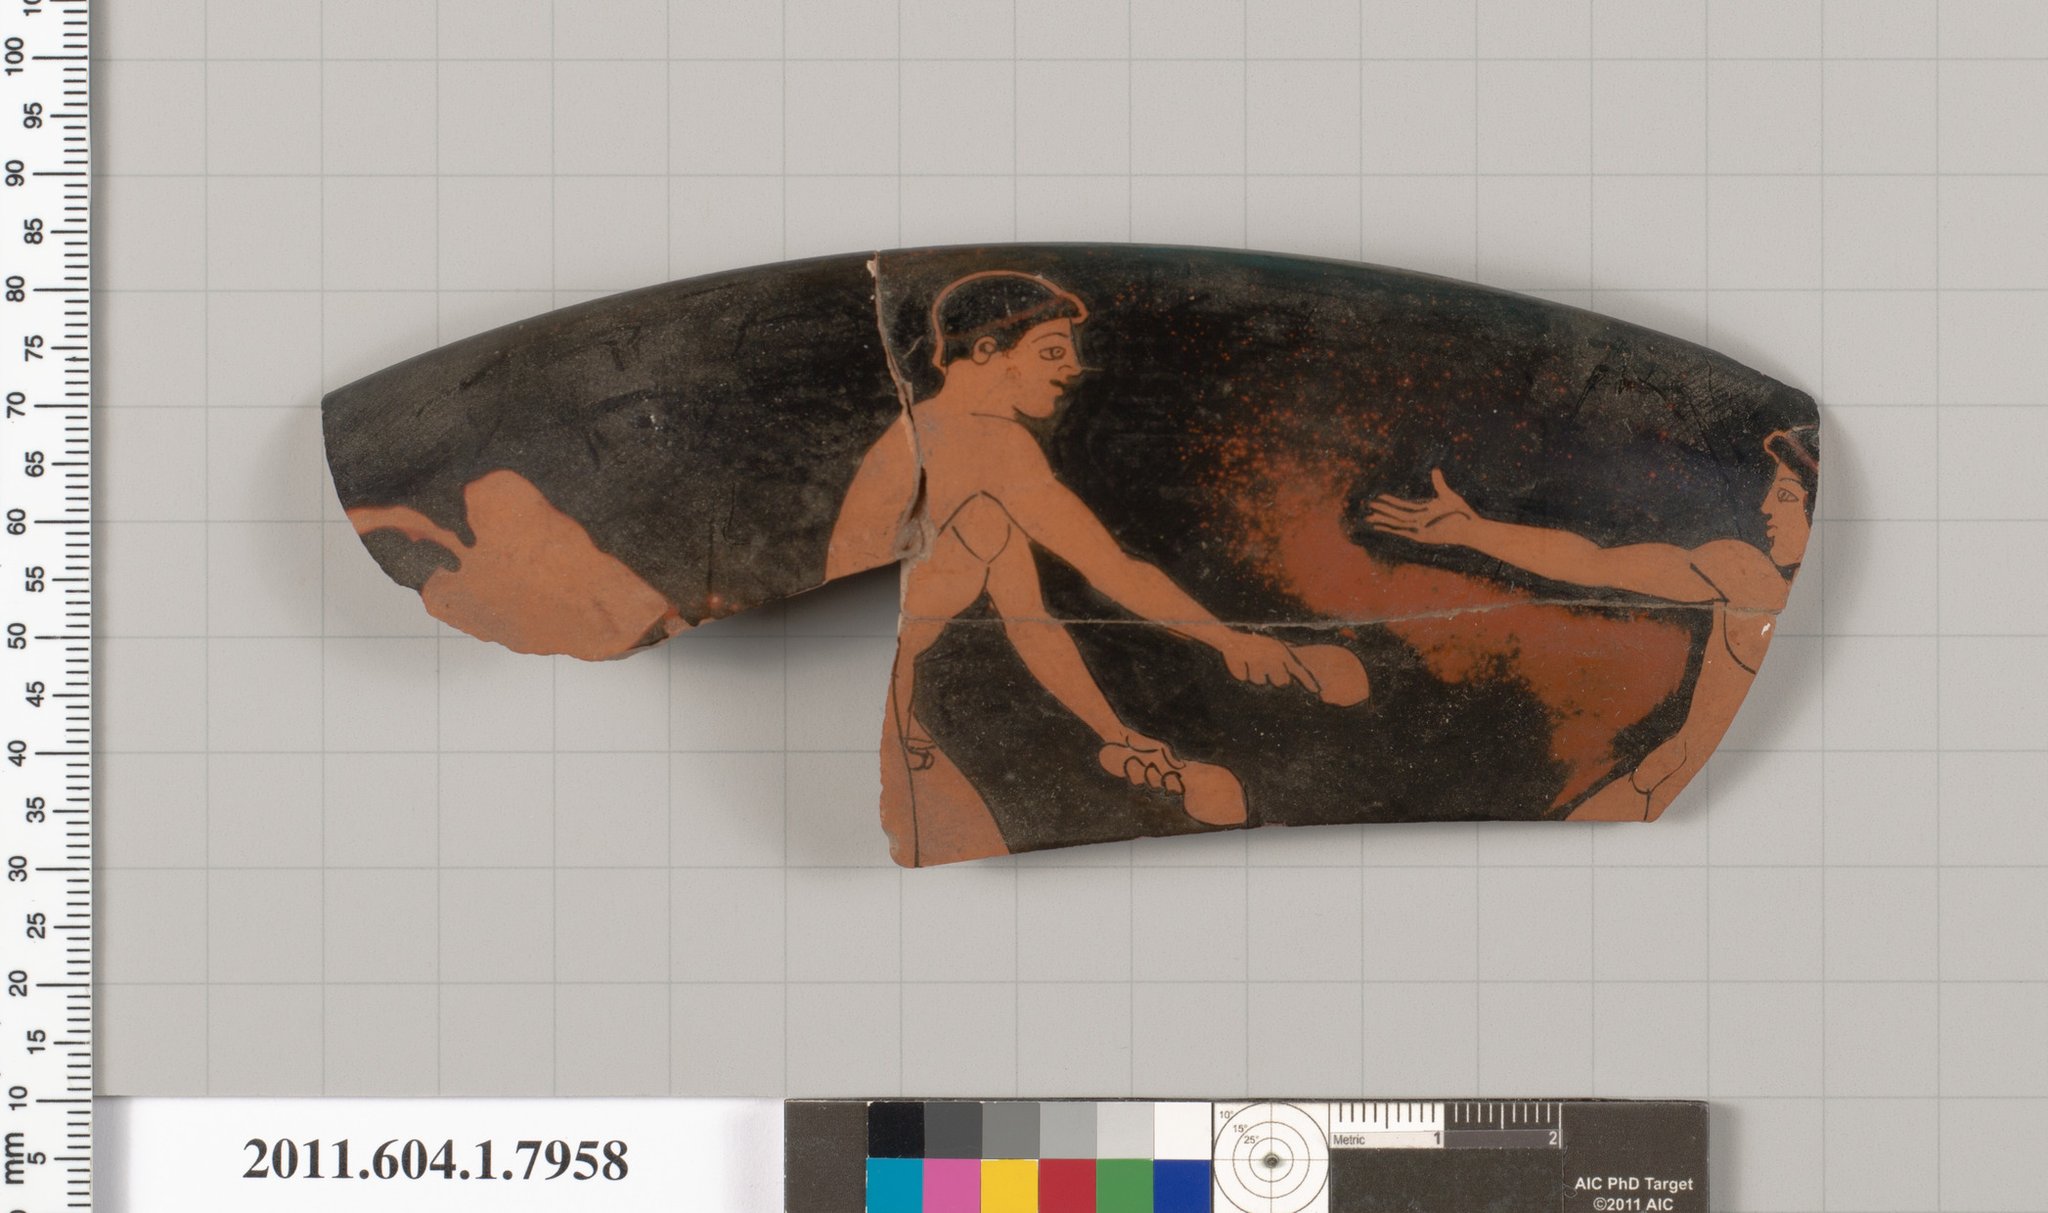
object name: kylix fragment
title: Terracotta rim fragment of a kylix (drinking cup)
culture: greek, attic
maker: villa giulia painter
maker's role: artist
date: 460-450 BCE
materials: terracotta